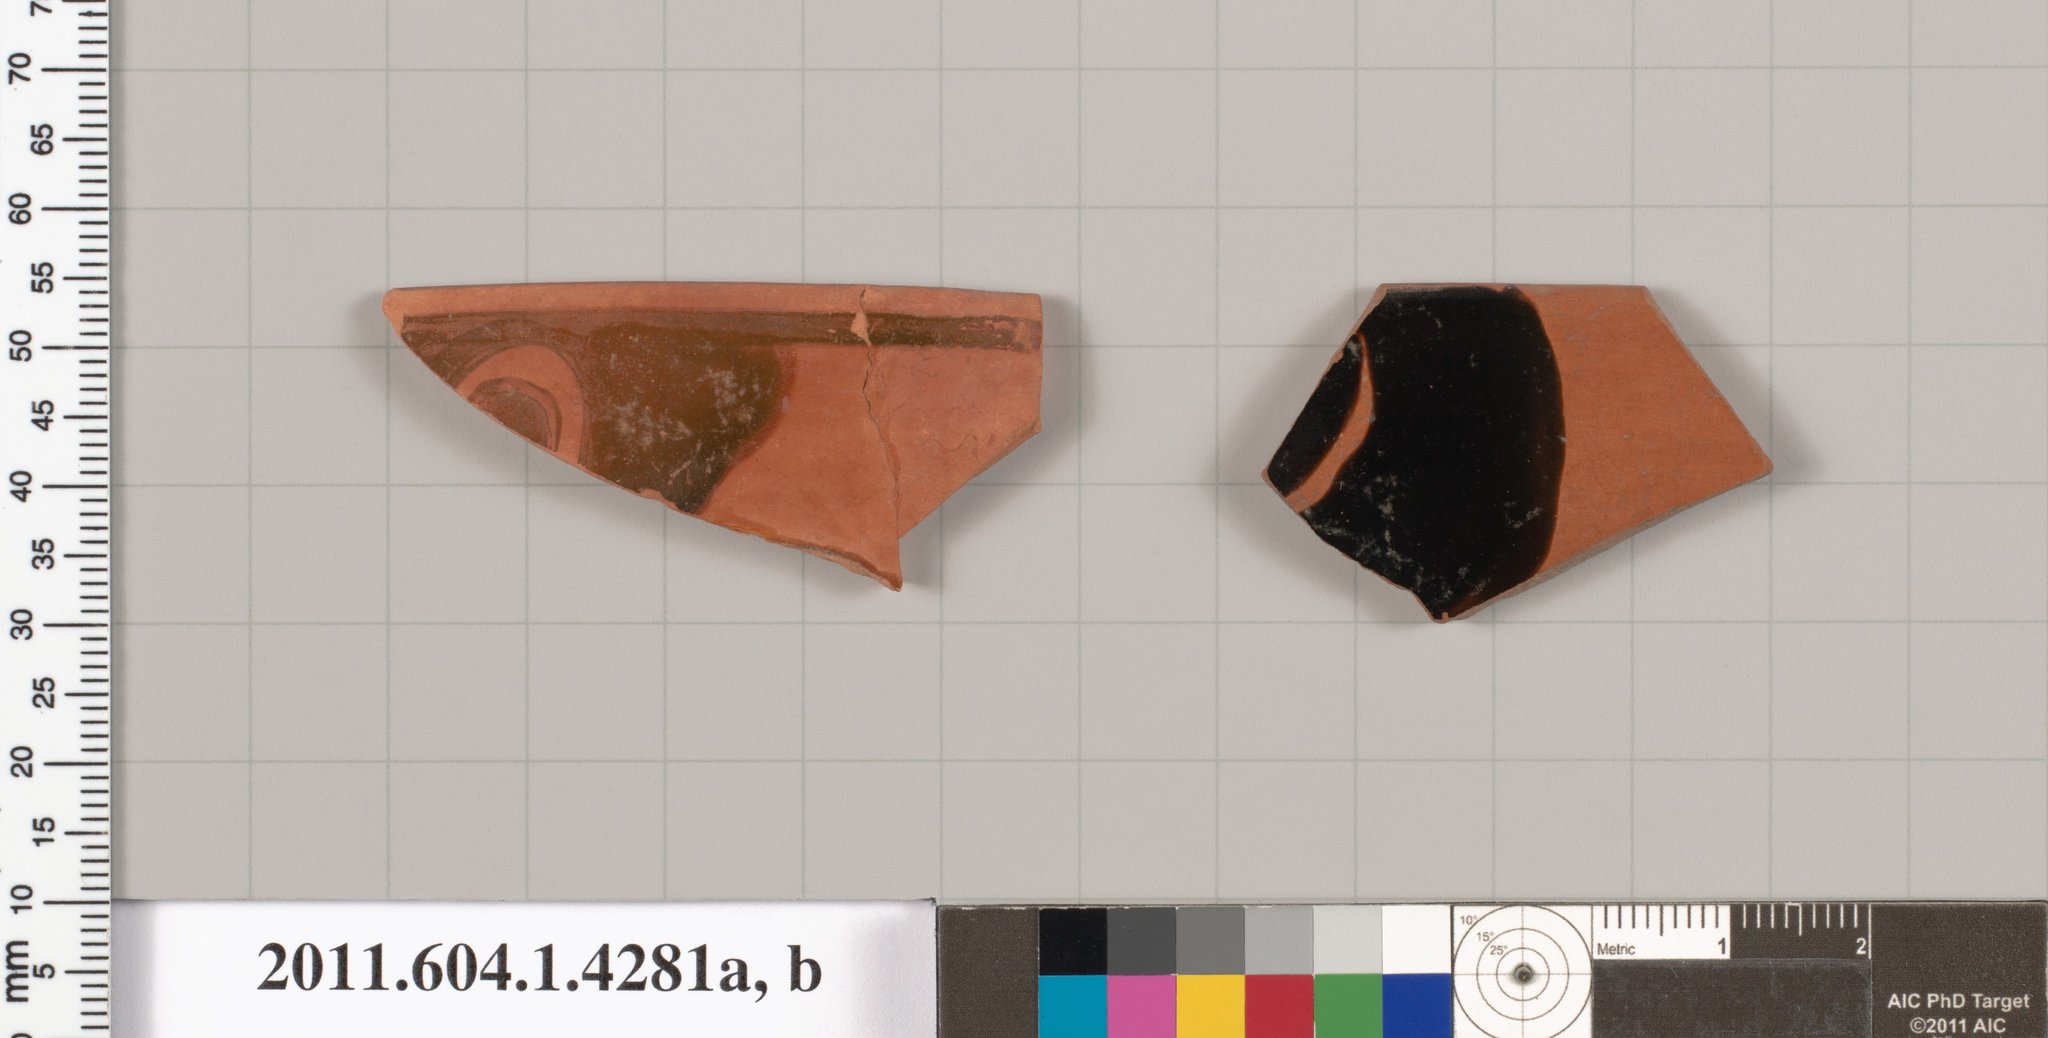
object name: kylix fragment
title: Terracotta rim fragments of kylikes (drinking cups)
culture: greek, attic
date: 500-451 BCE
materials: terracotta